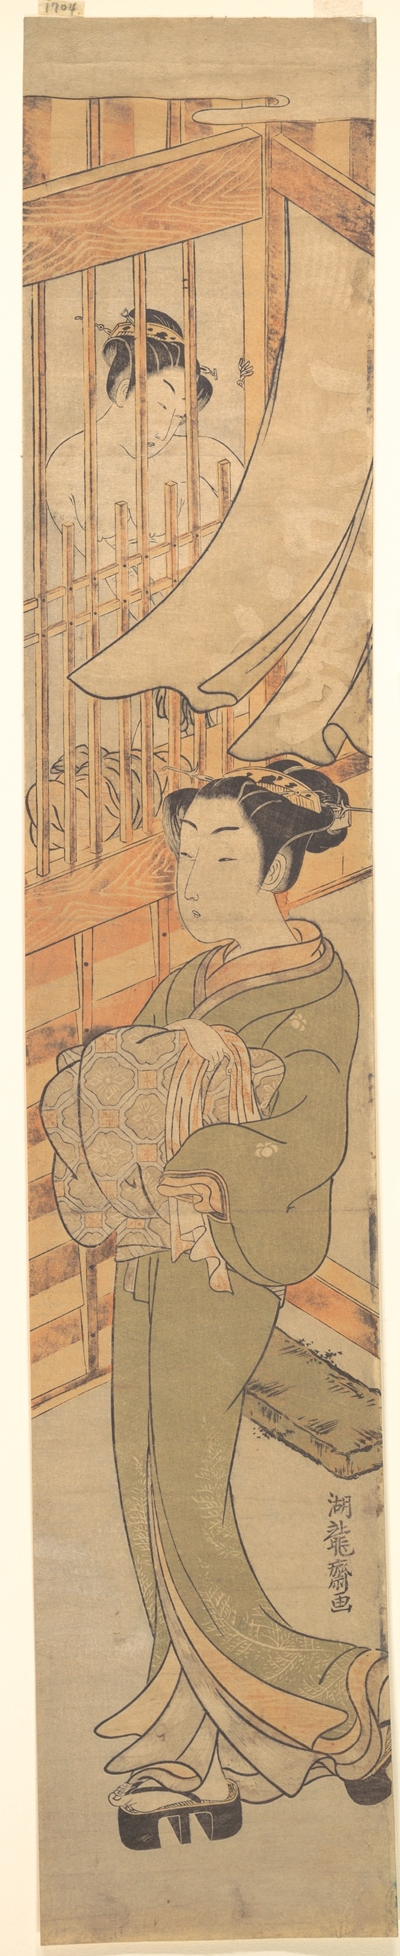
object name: print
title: In the Yoshiwara District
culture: japanese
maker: isoda koryūsai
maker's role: artist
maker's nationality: japanese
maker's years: 1735-1790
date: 1767-1800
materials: ink, paper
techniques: woodblock print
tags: women